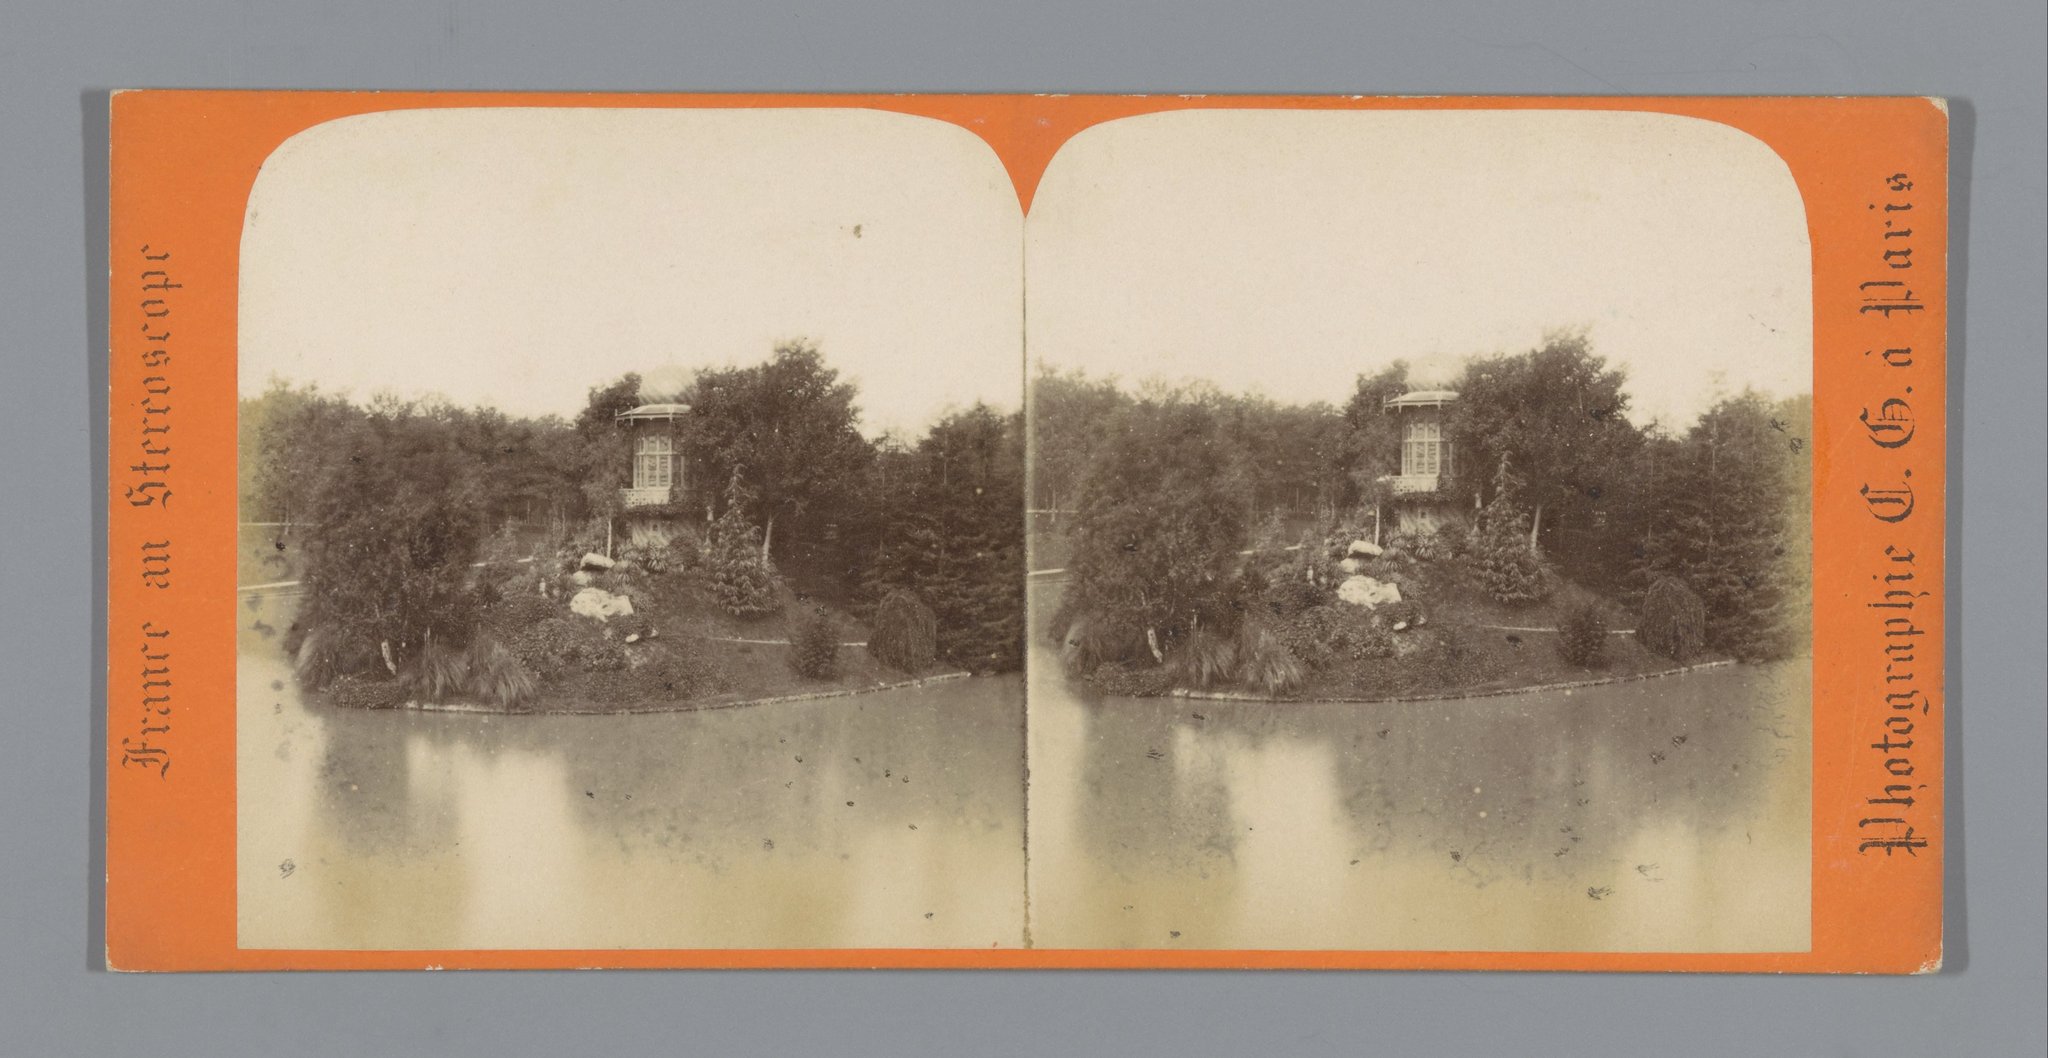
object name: stereograph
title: France au Stereoscope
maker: charles gérard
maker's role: fotograaf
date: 1850-1875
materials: cardboard, photographic support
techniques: albumen print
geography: bois de boulogne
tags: book-stall, kiosk, river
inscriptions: inscription: ‘Kiosque au bois de Boulogne Paris’